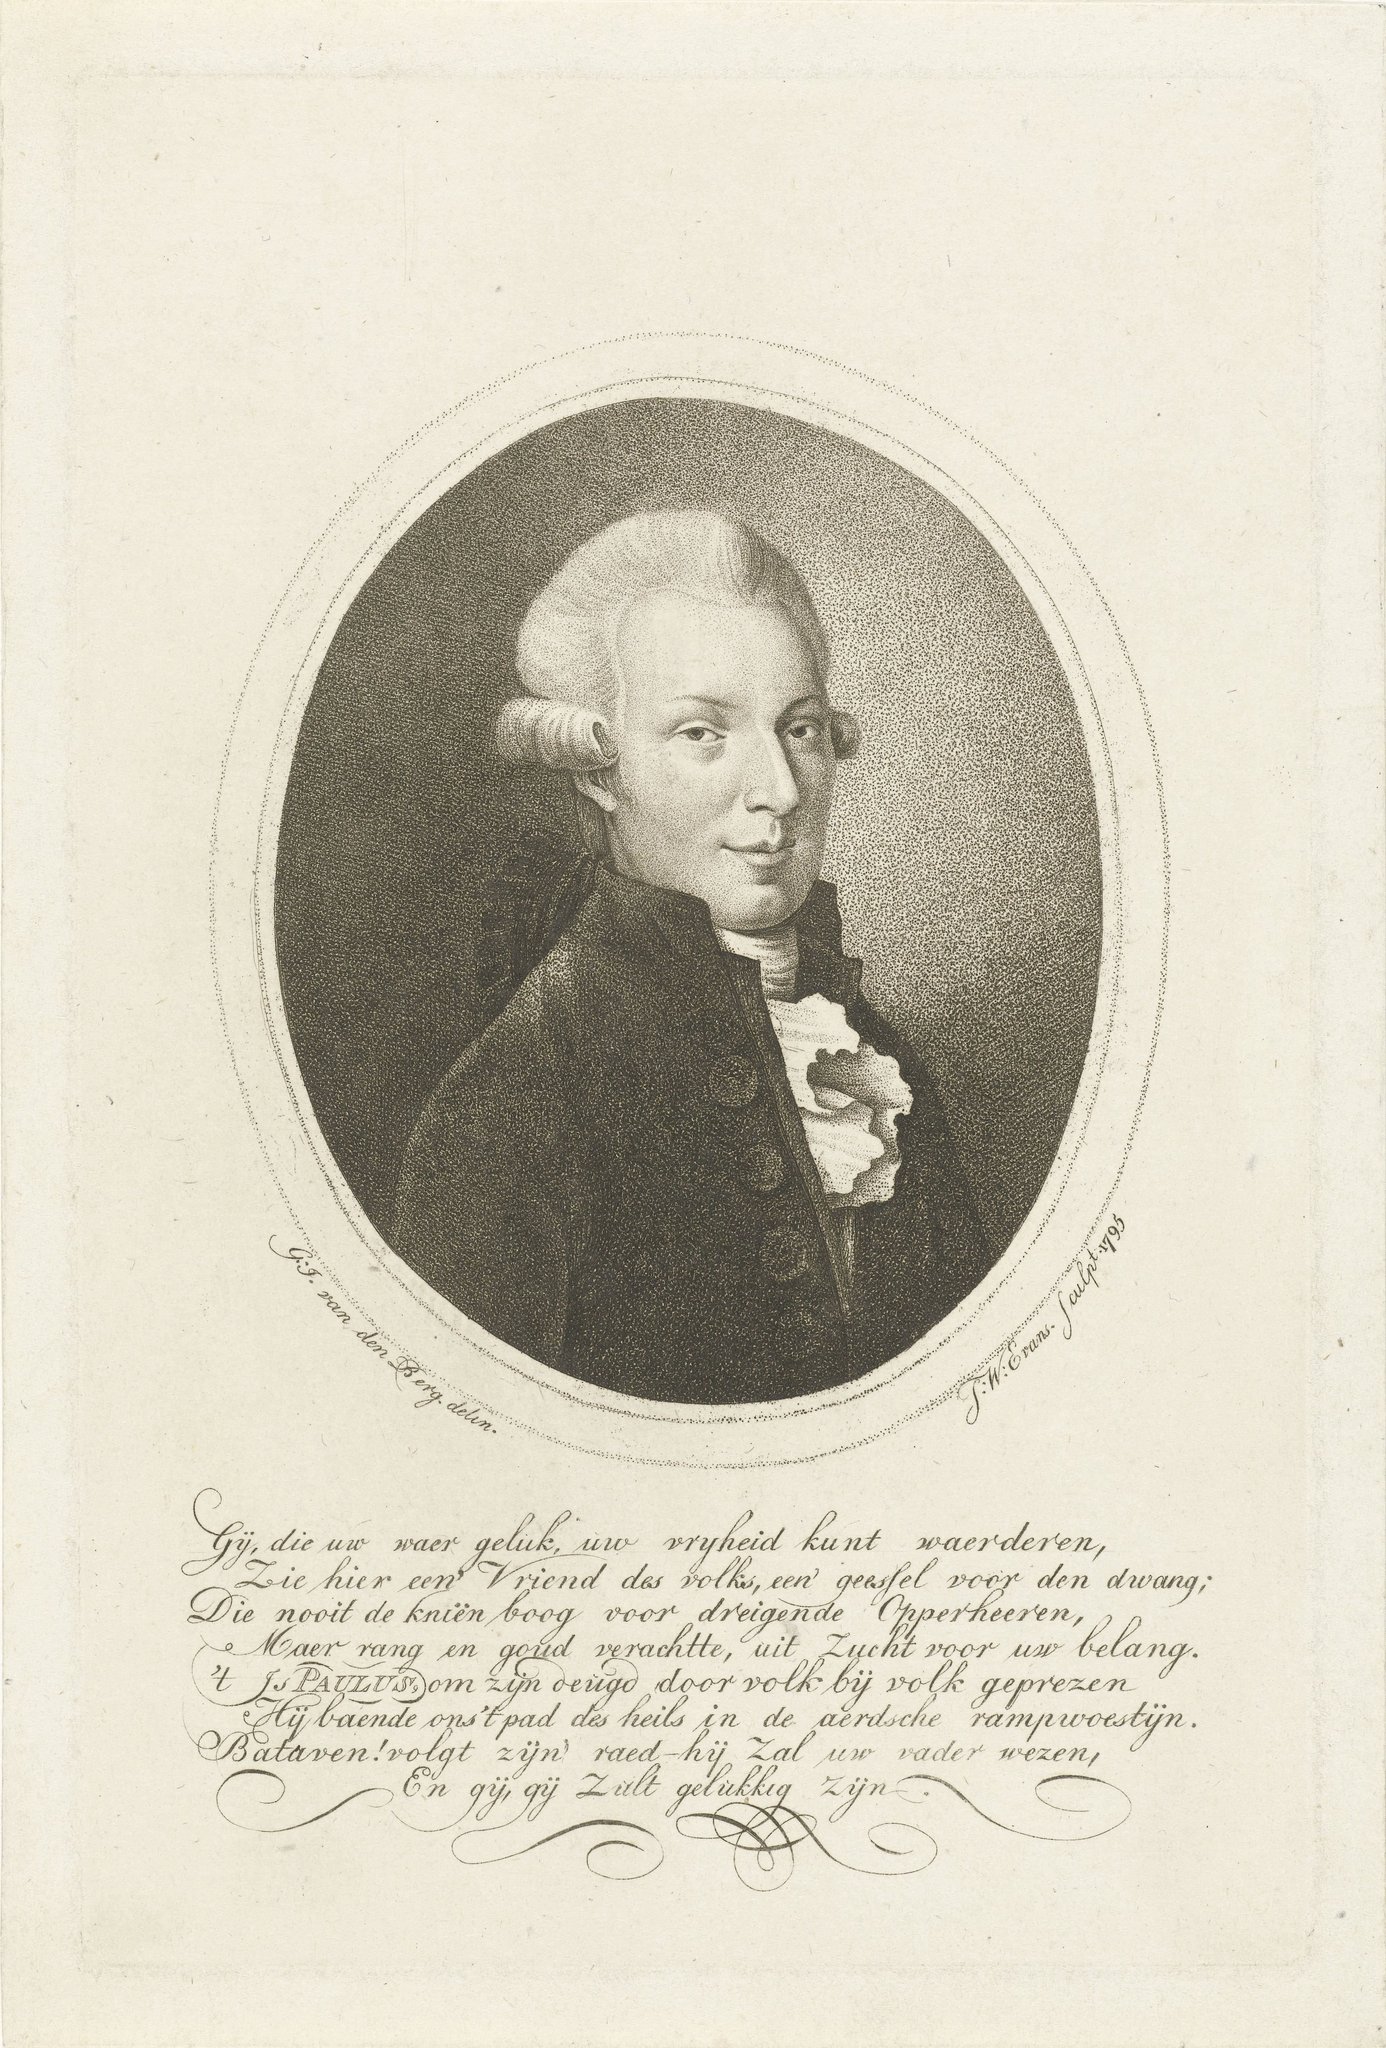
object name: print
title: Portret van Pieter Paulus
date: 1795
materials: paper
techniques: etching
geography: rotterdam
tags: pieter paulus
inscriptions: collector's mark: Lugt 2228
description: Ovaal busteportret van de politicus Pieter Paulus. Onder het portret een Nederlands vers van acht regels.